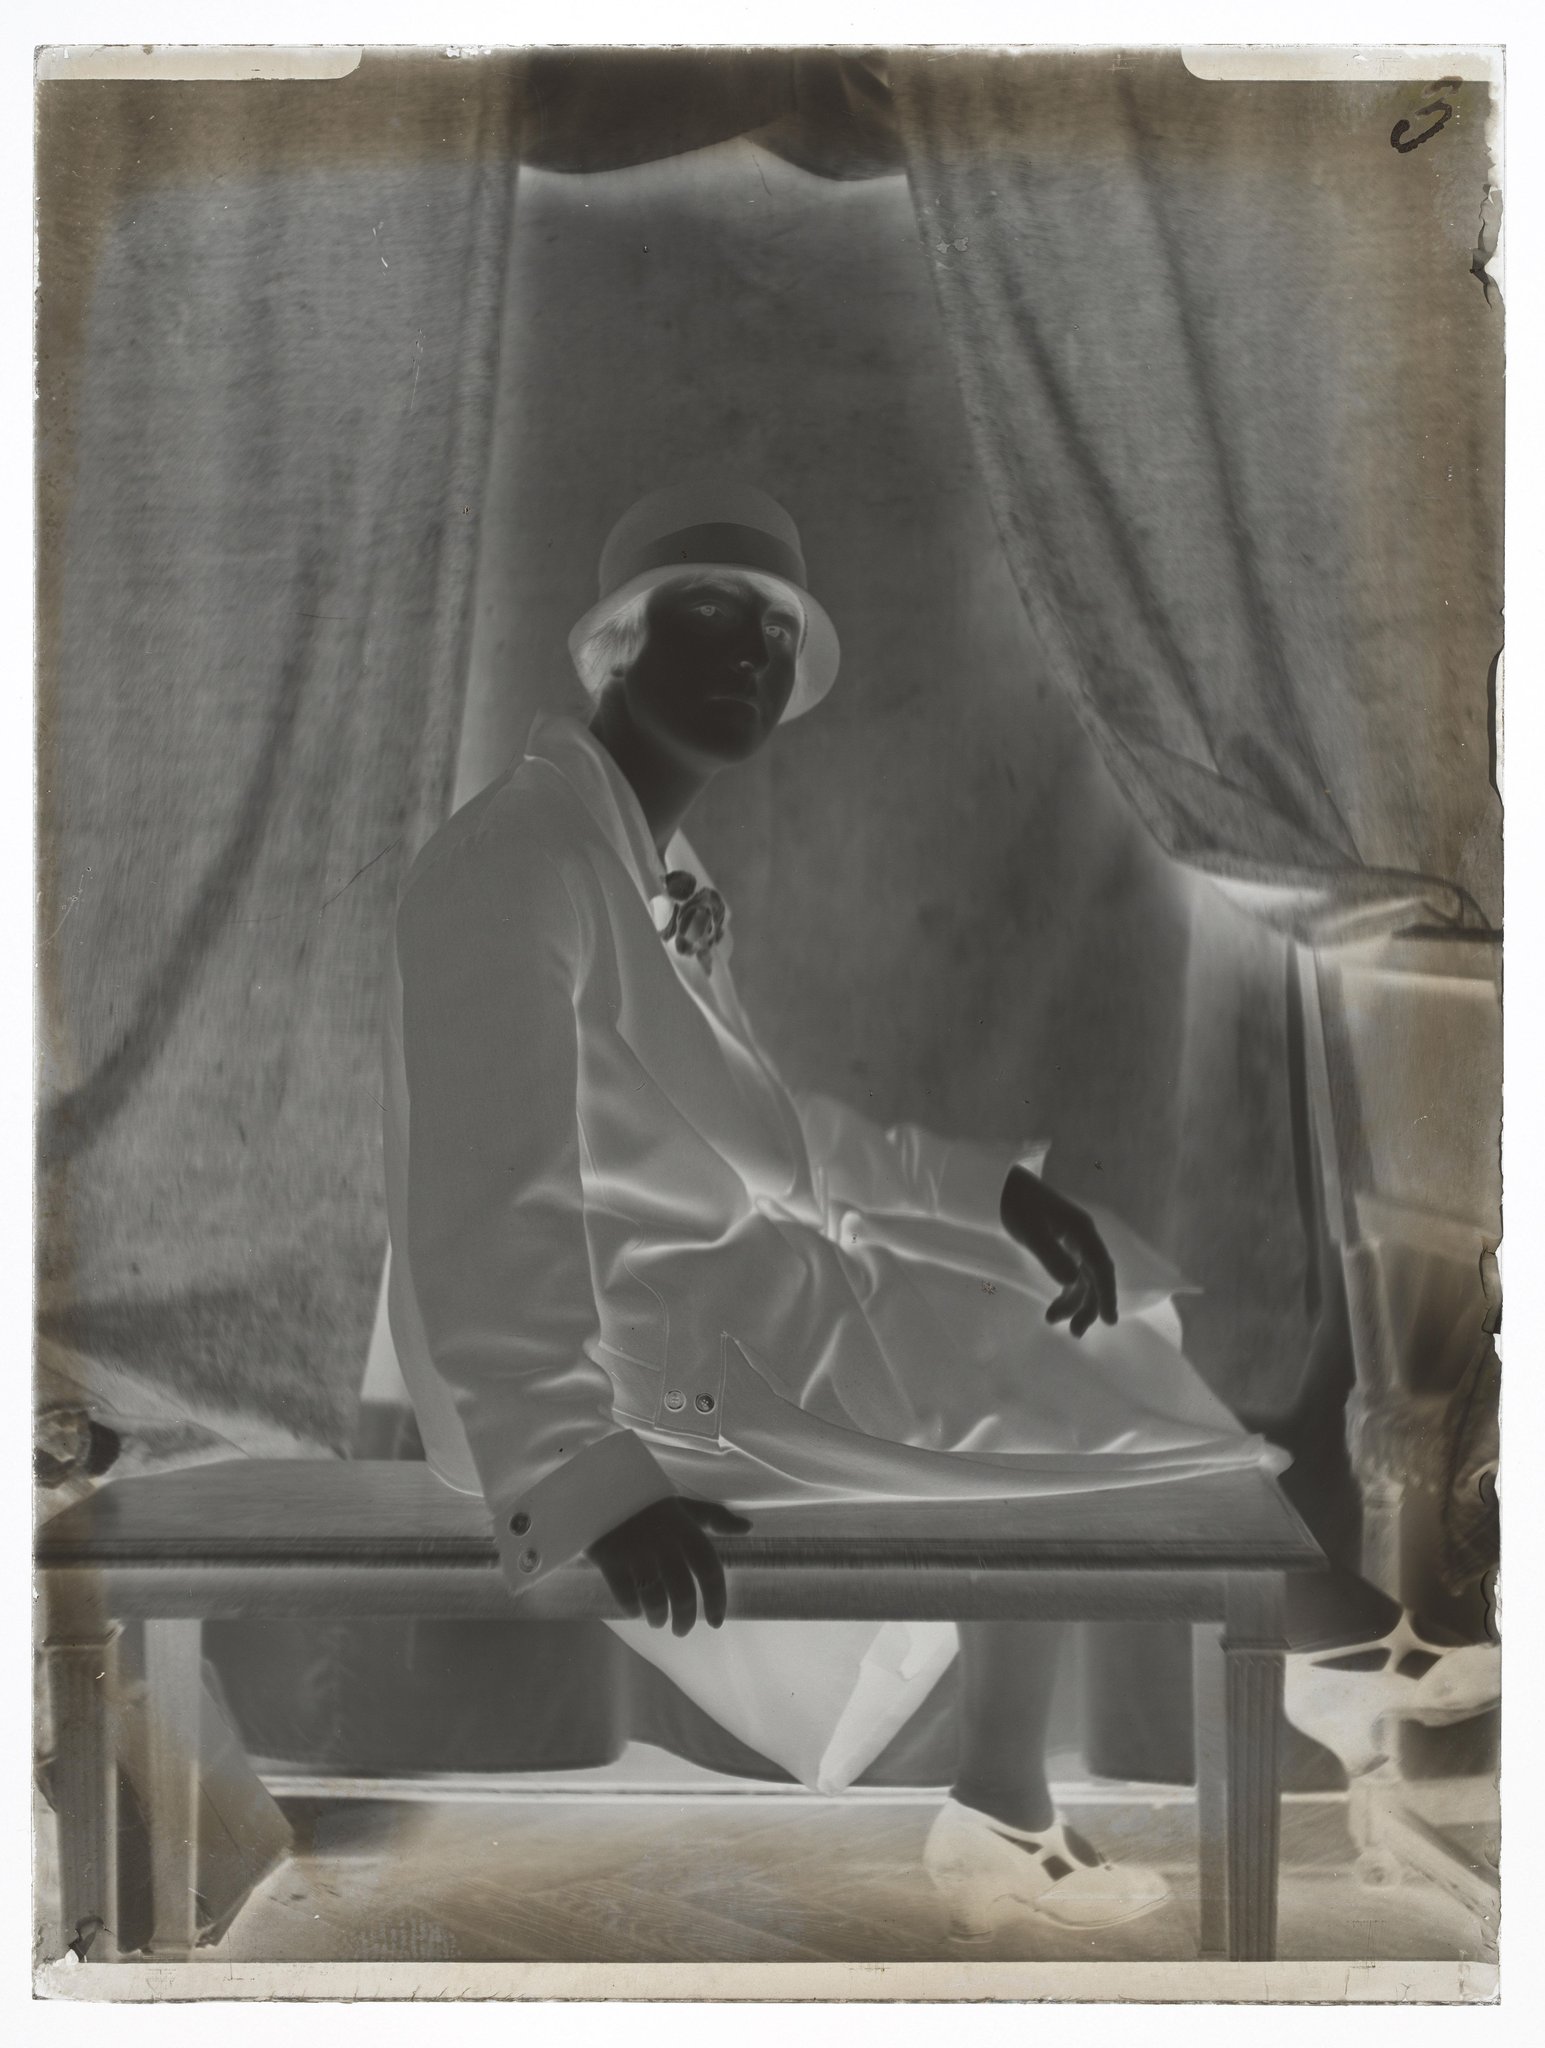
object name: glasnegatief, glasplaatnegatief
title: Portret van Mies Rosenboom-Merkelbach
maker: jacob merkelbach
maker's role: fotograaf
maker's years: 1877-1942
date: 1920-1930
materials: glass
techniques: jos-pé print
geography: amsterdam